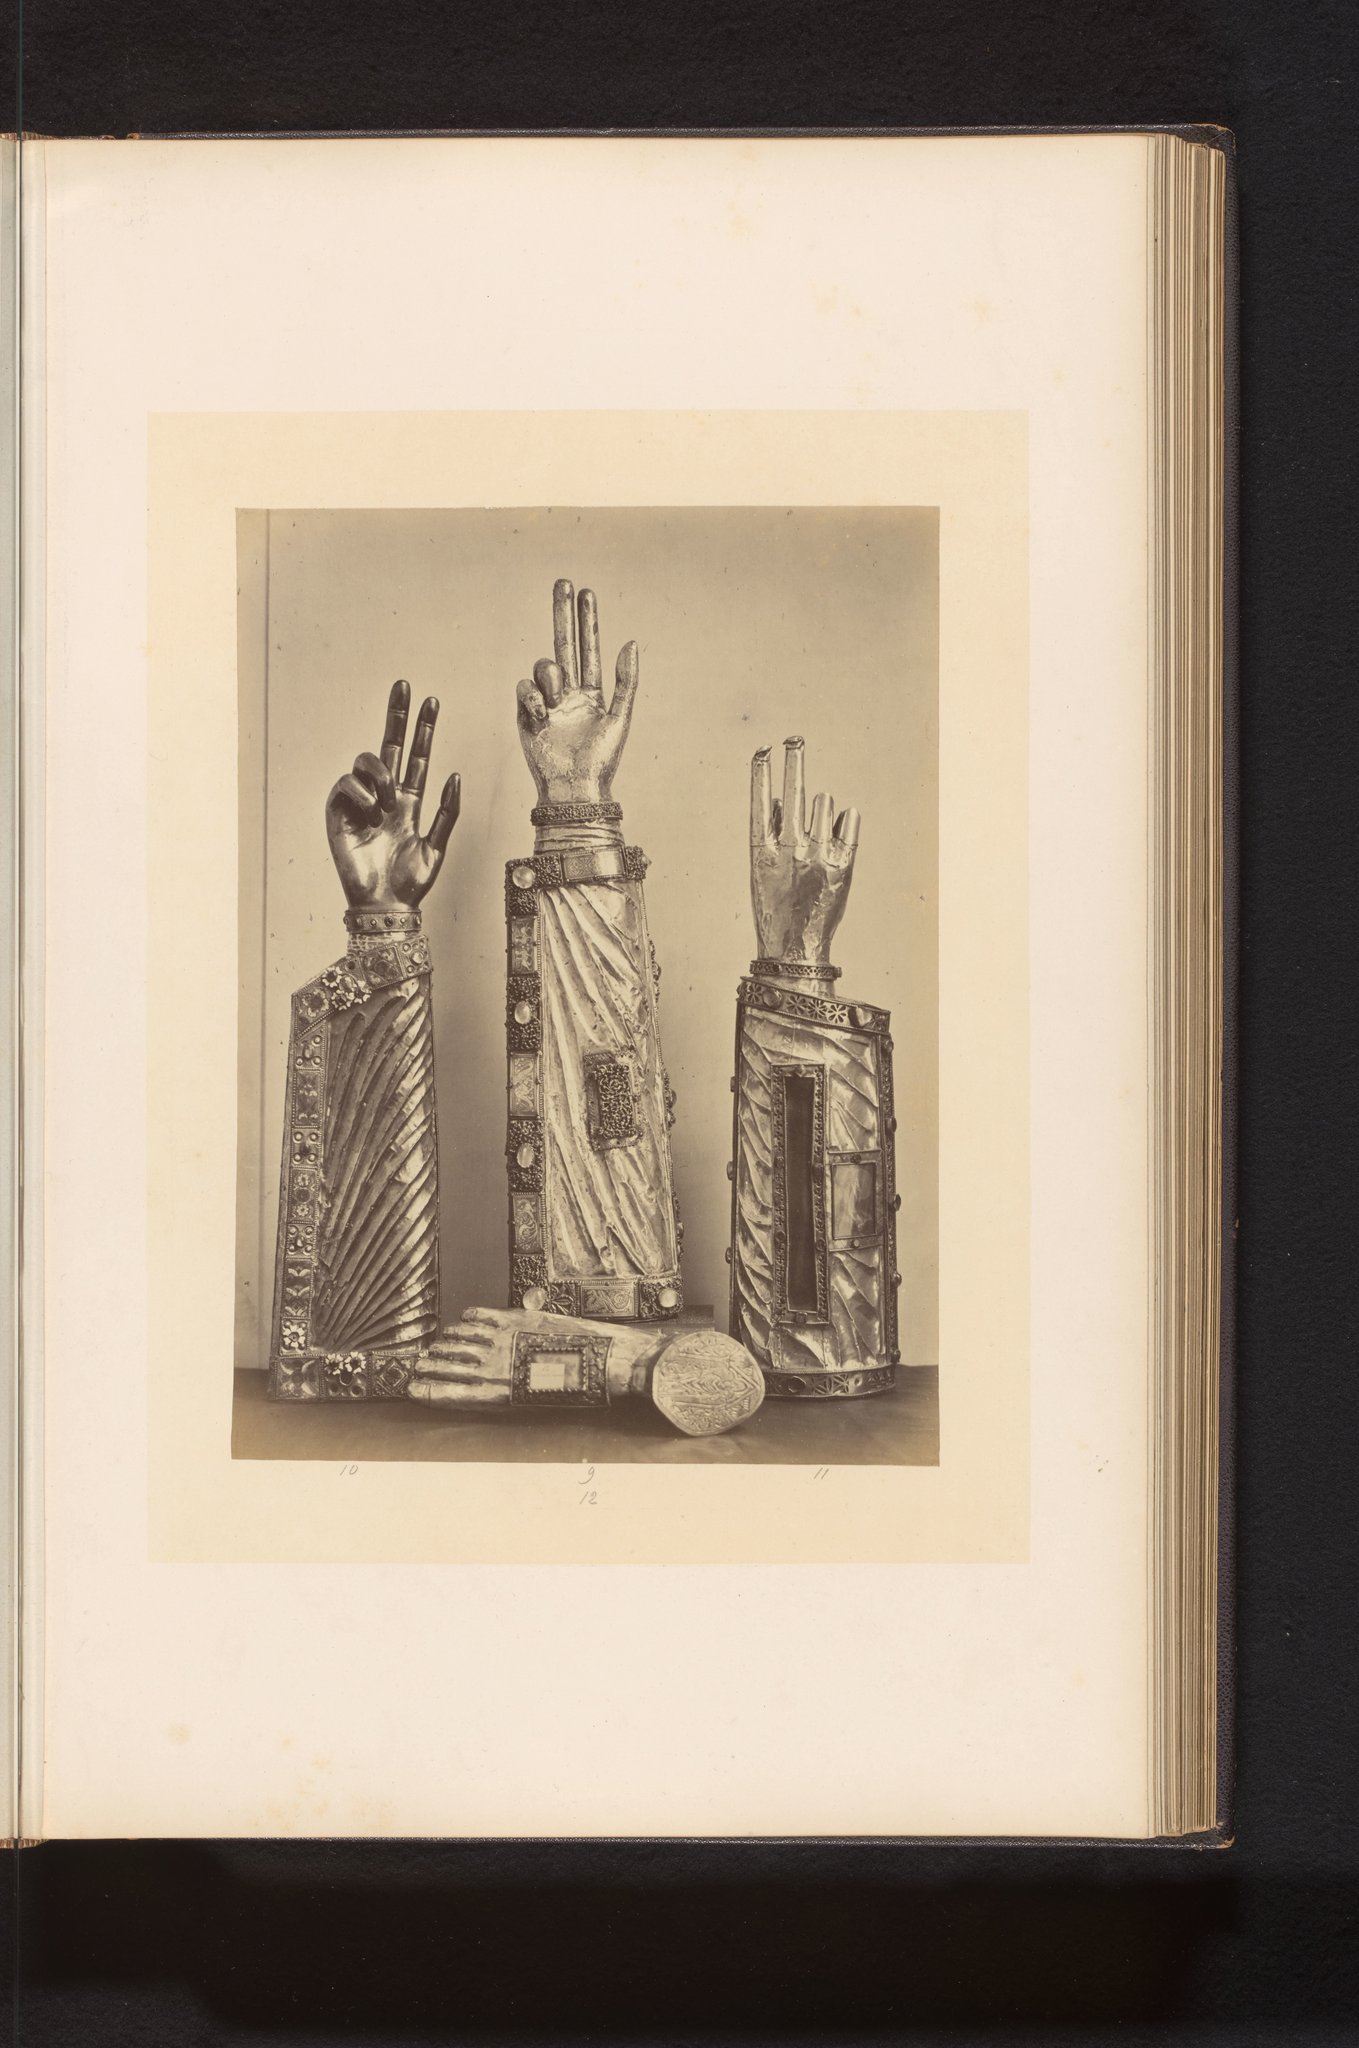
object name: page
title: Drie relikwieënkasten in de vorm van een hand en een relikwieënkast in de vorm van een voet, opgesteld op een tentoonstelling over religieuze objecten uit de middeleeuwen en renaissance in 1864 in Mechelen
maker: joseph maes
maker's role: fotograaf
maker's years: 1838-1908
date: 1864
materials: photographic support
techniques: albumen print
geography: mechelen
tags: piece of sculpture, reproduction of a piece of sculpture (+ metals ~ arts), relics (and reliquaries), mechelen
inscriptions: number: ‘10 - 9 - 11/ 12’